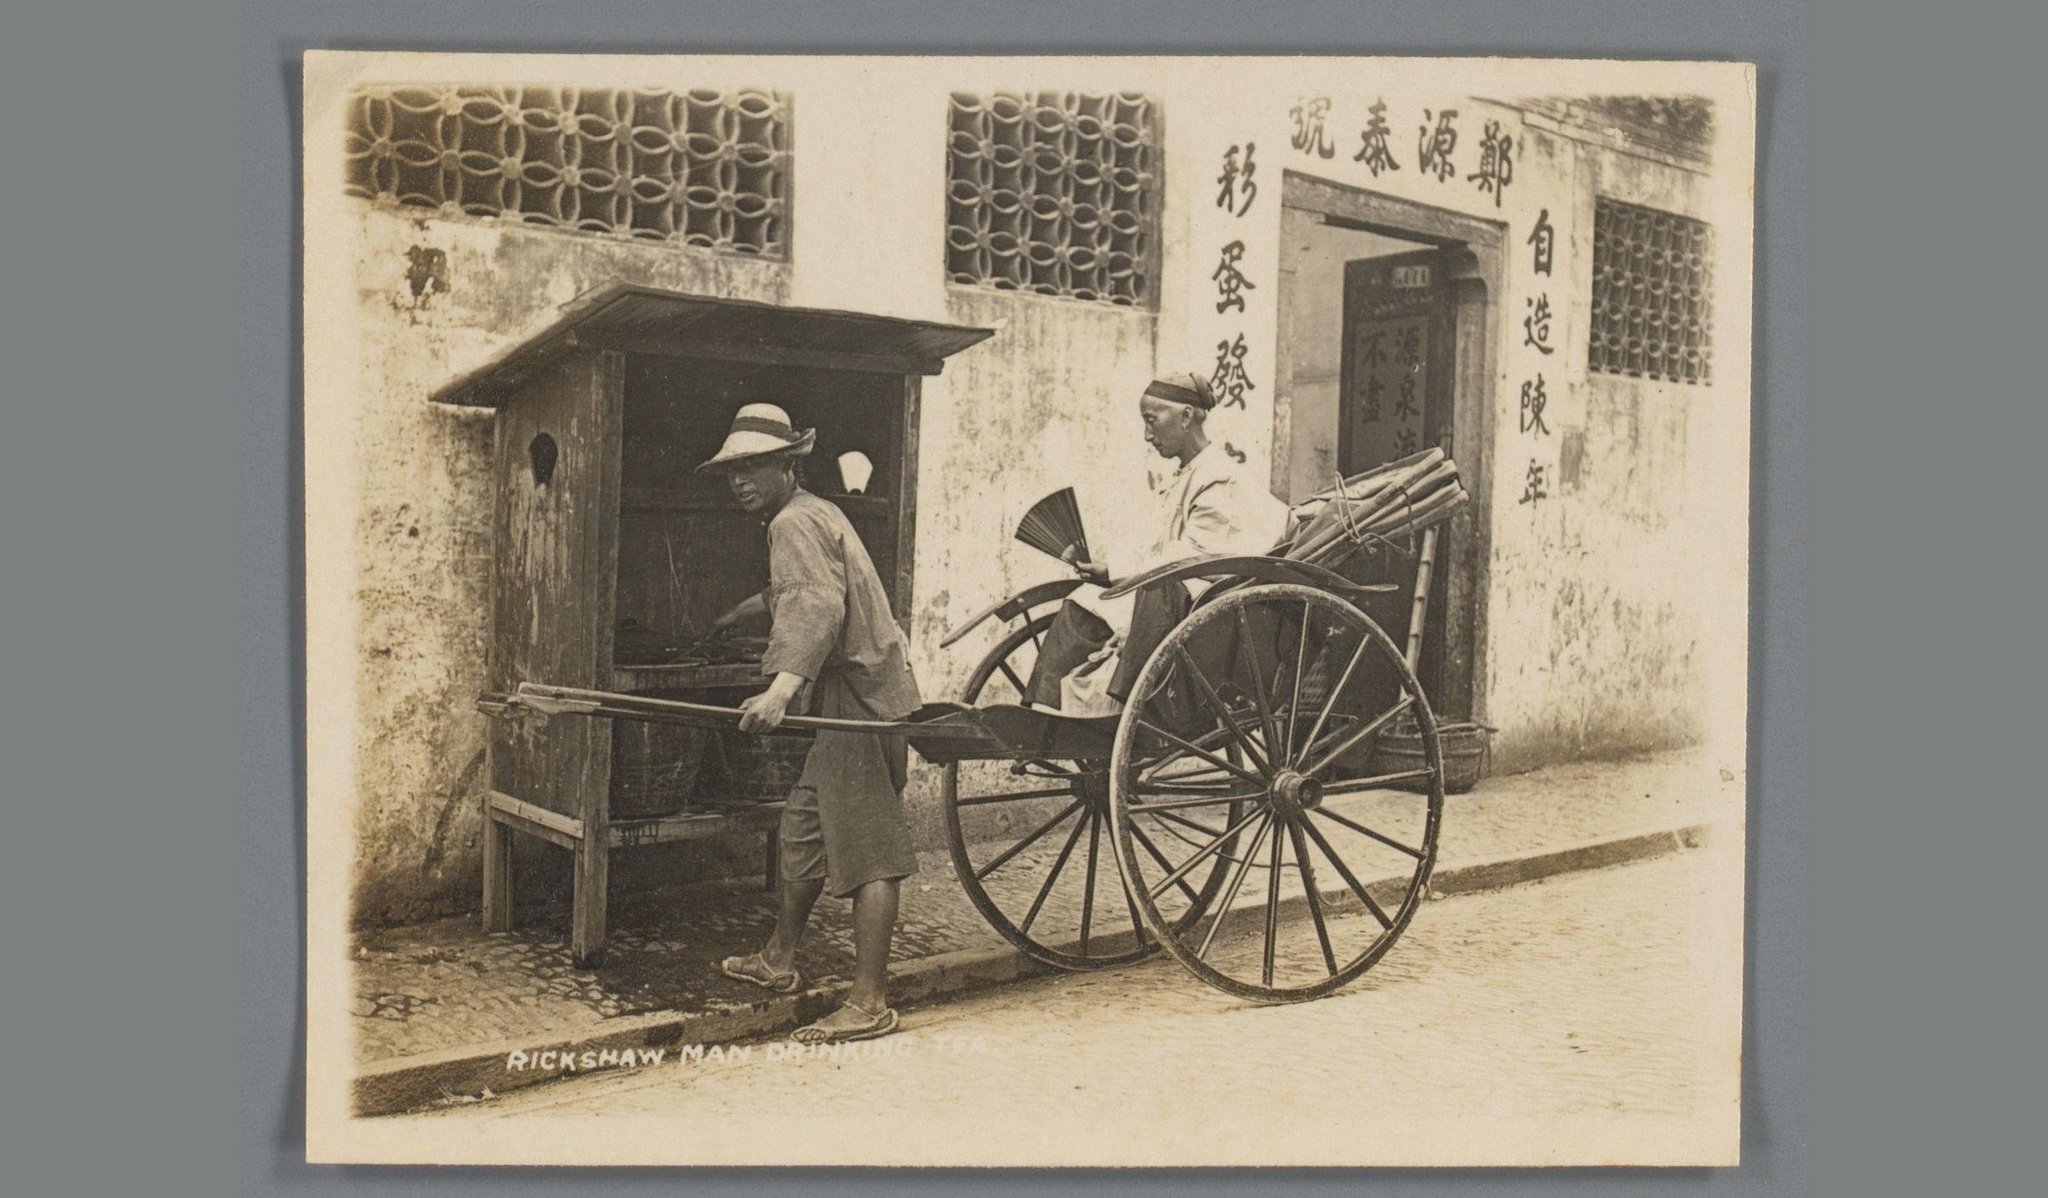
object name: photograph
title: Man met riksja drinkt thee langs de weg, Shanghai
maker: Anonymous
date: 1910-1930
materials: paper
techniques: gelatin silver print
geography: shanghai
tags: rickshaw, cup of tea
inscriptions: stamp: ‘Copyright Photograph by Mactavish & Co., Ltd./ Shanghai.’